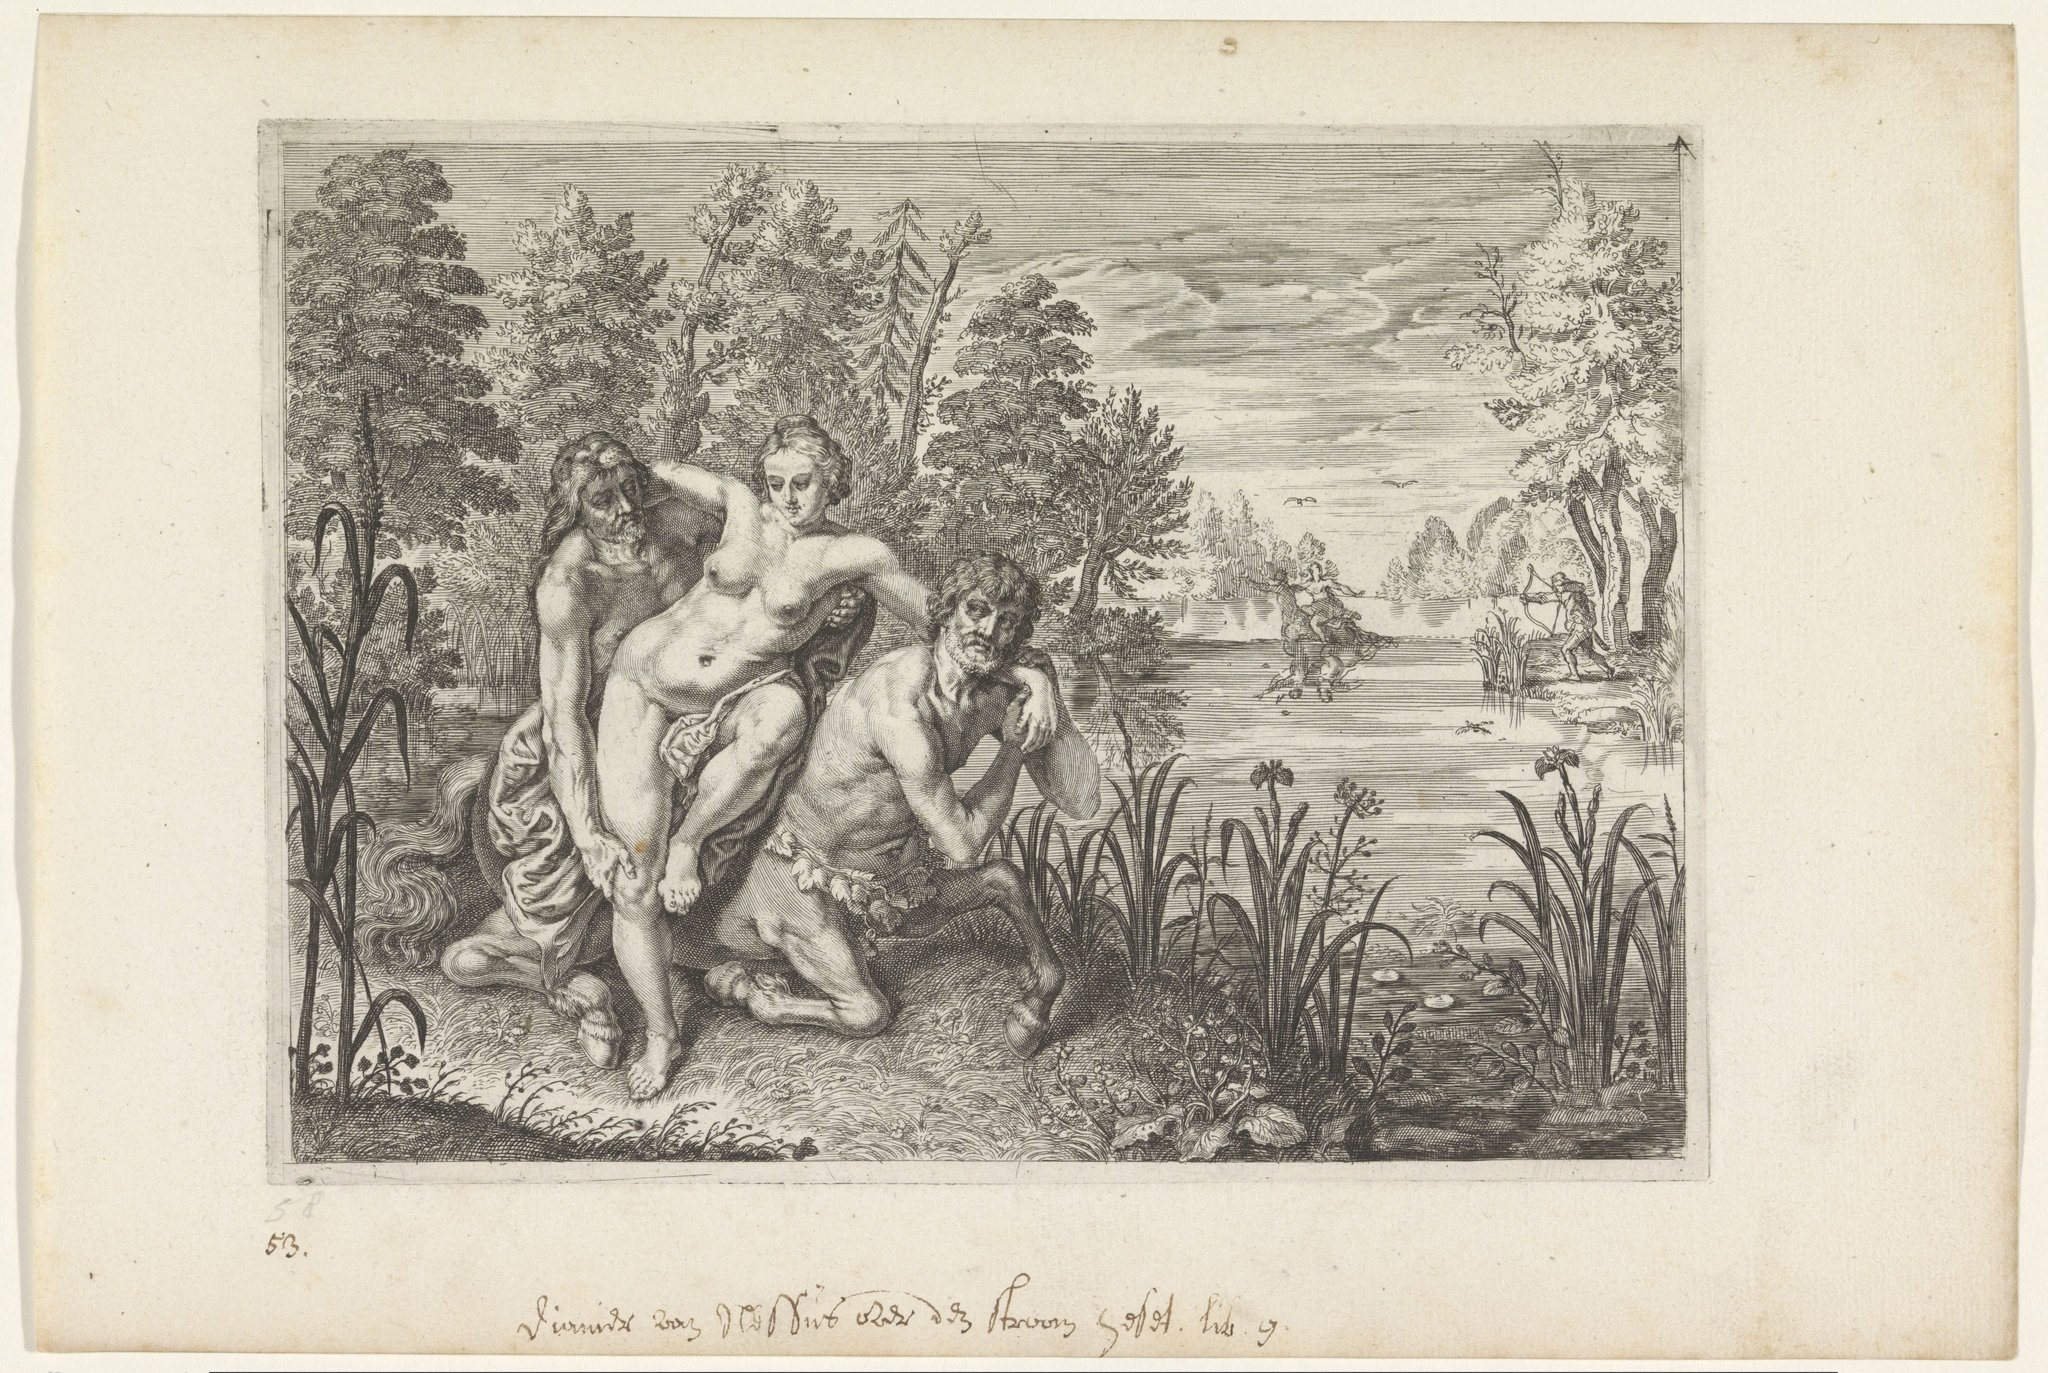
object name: print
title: Nessus zet Deïanira de rivier over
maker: crispijn van de passe (ii)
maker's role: draughtsman, print maker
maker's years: 1594-1670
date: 1636-1670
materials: paper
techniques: engraving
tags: hercules shoots nessus, the centaur, who attempts to carry off deianira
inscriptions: annotation: ‘Dianier van Nessus over den stroom geset. lib. 9.’, collector's mark: ‘Hinloopen’, number: ‘53’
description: Deze incomplete serie, bestaande uit 77 van de in totaal 85 prenten met scènes uit Ovidius' Metamorfosen, werd in 1709 samen met Ovidius-illustraties van Tempesta, Goltzius en Le Pautre in één album, Schijnvoet nummer 43, ingebonden. In de negentiende eeuw werd deze band weer uit elkaar gehaald.